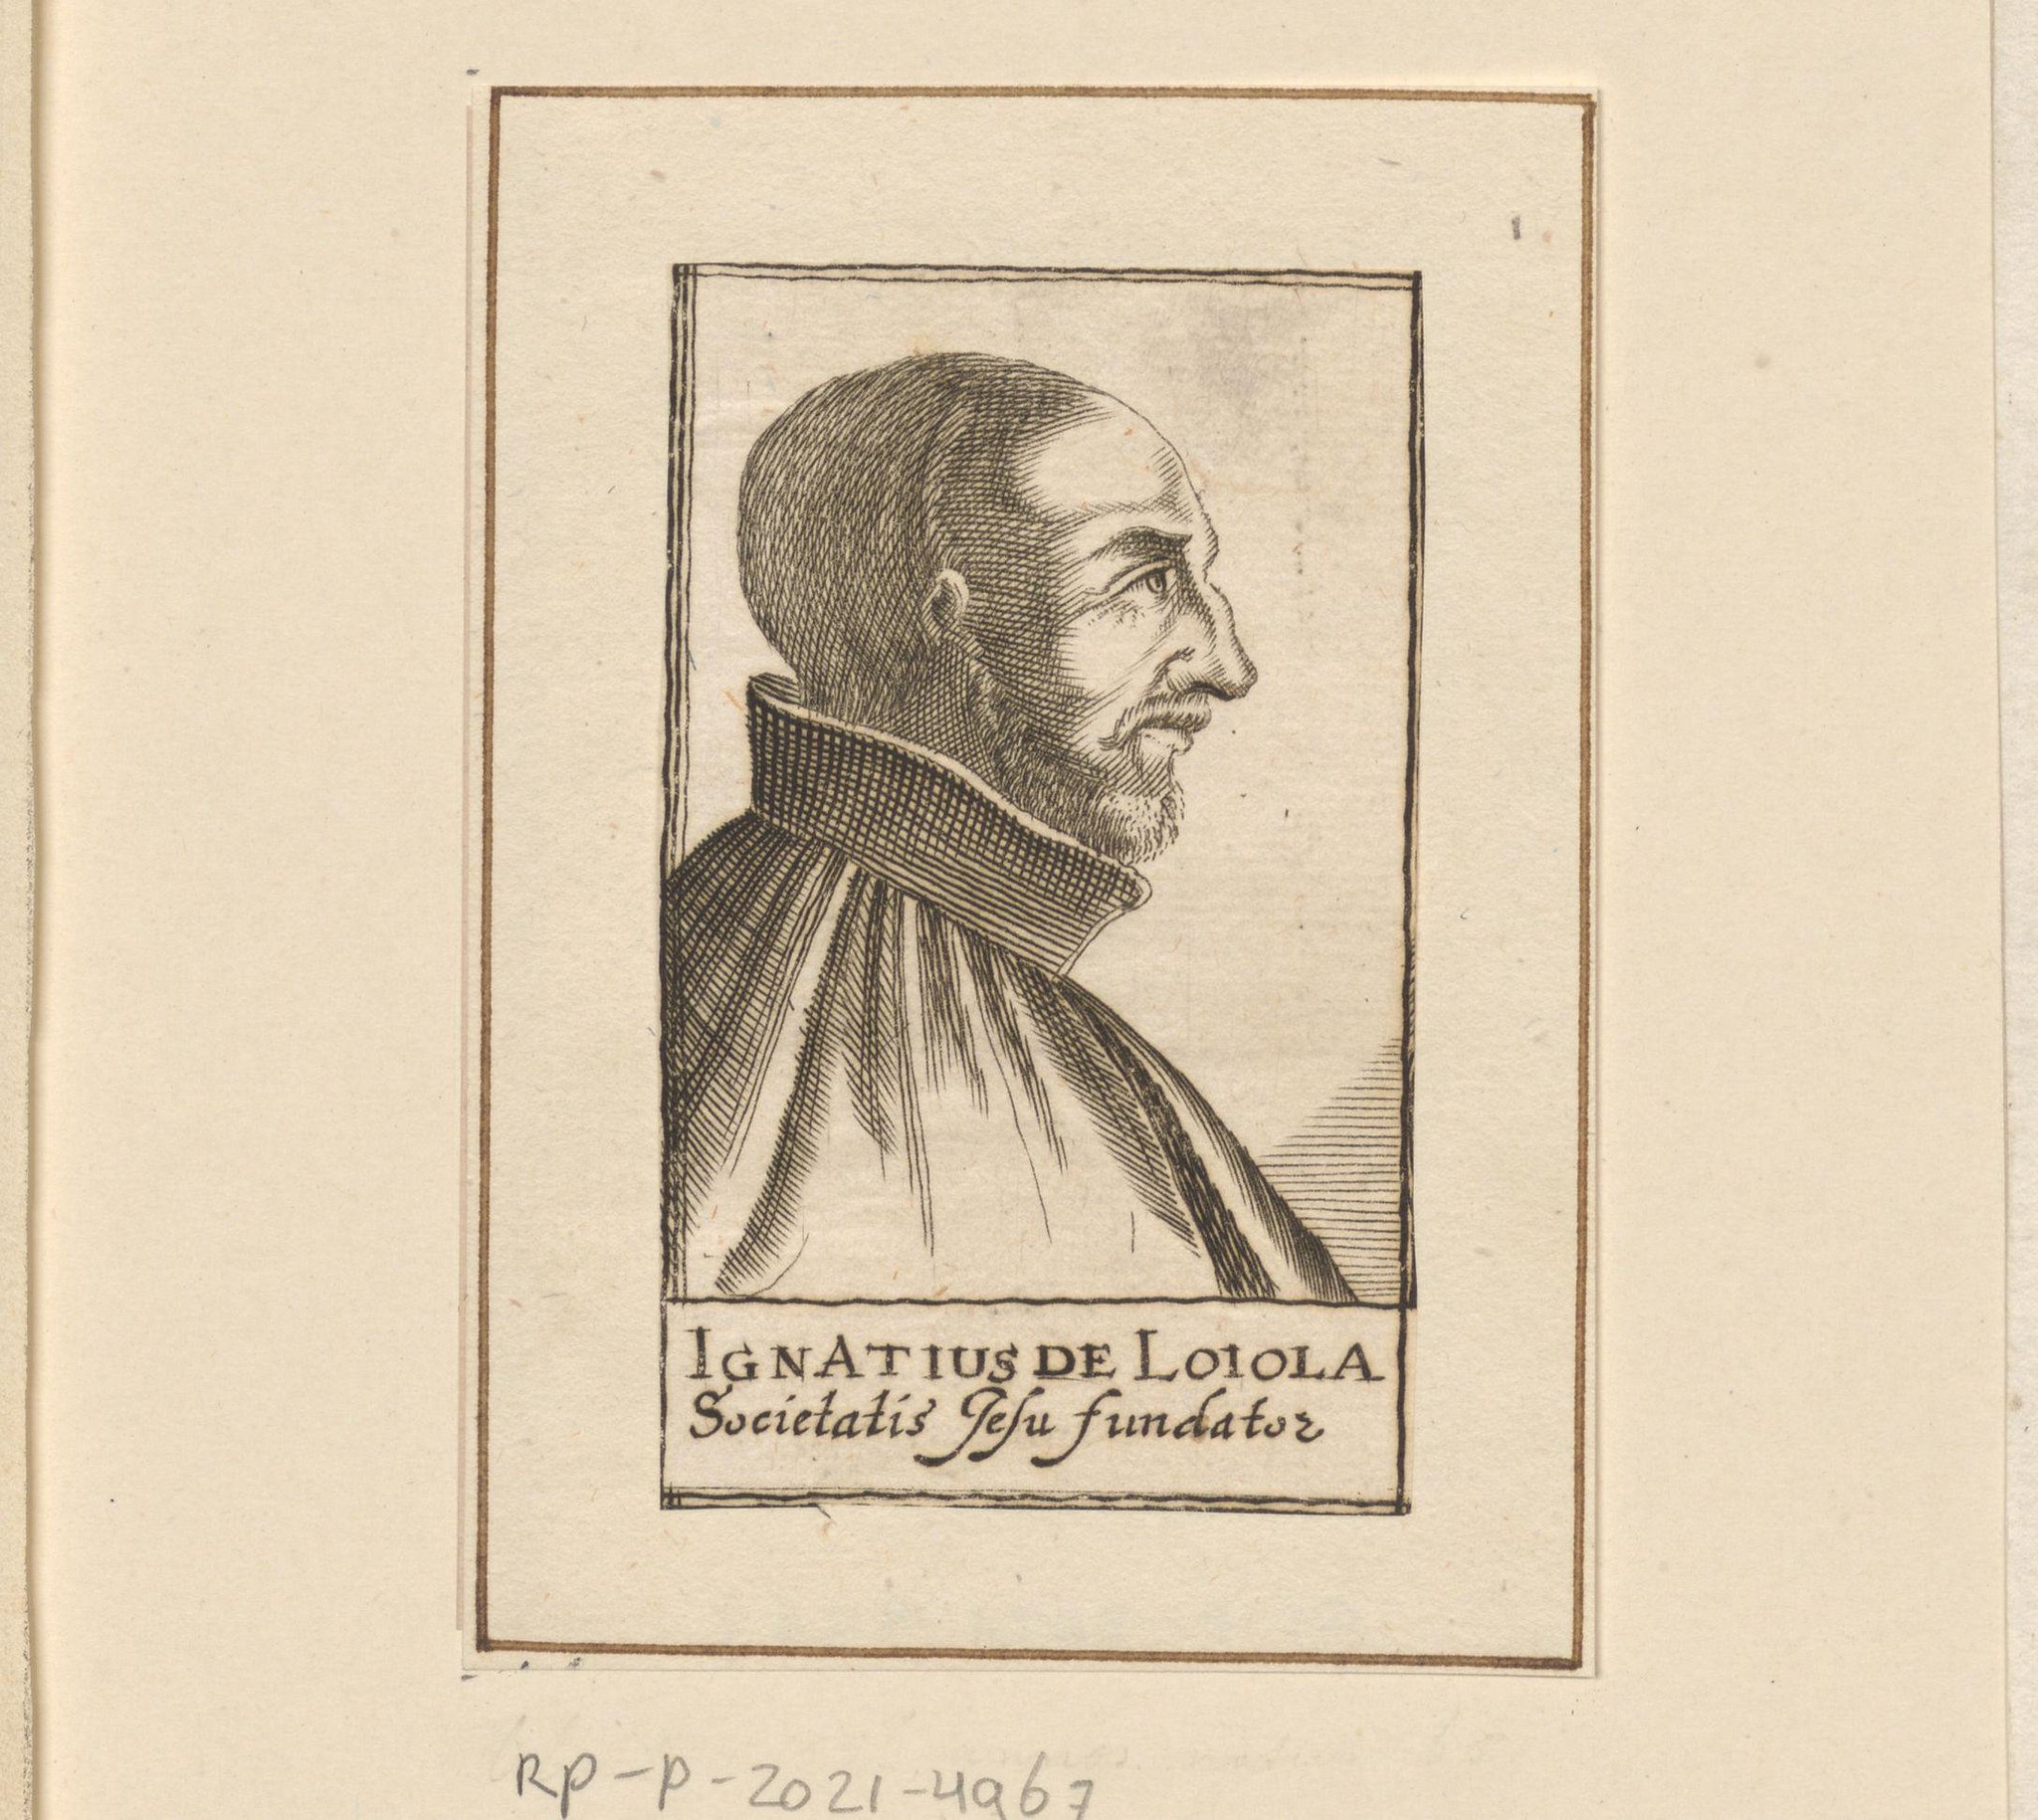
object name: book illustration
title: Portret van Ignatius van Loyola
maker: Anonymous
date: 1688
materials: paper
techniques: engraving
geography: germany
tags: rome, clergyman, historical persons, the founder of the jesuit order, ignatius of loyola; possible attributes: book (with 'ad majorem dei gloriam'), demon, dragon under feet, flames, flaming heart, globe, ihs monogram, skull (with crown), tears in eyes, torch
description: Prent waarschijnlijk uit: Freher, Paul. Theatrum virorum eruditione clarorum. Neurenberg: Johann Hoffmann, 1688.